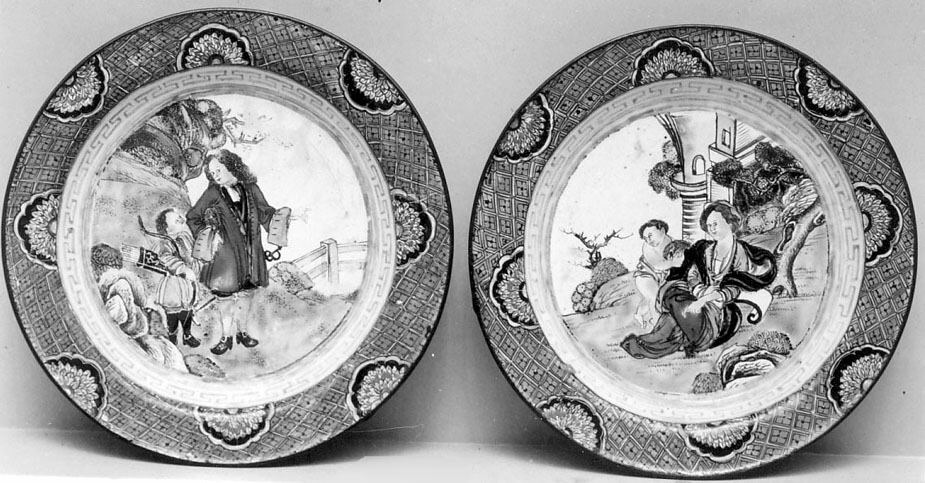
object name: dish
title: Dish with European Woman and Child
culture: chinese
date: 1767-1900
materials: copper, enamel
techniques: painting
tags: boys,women,trees